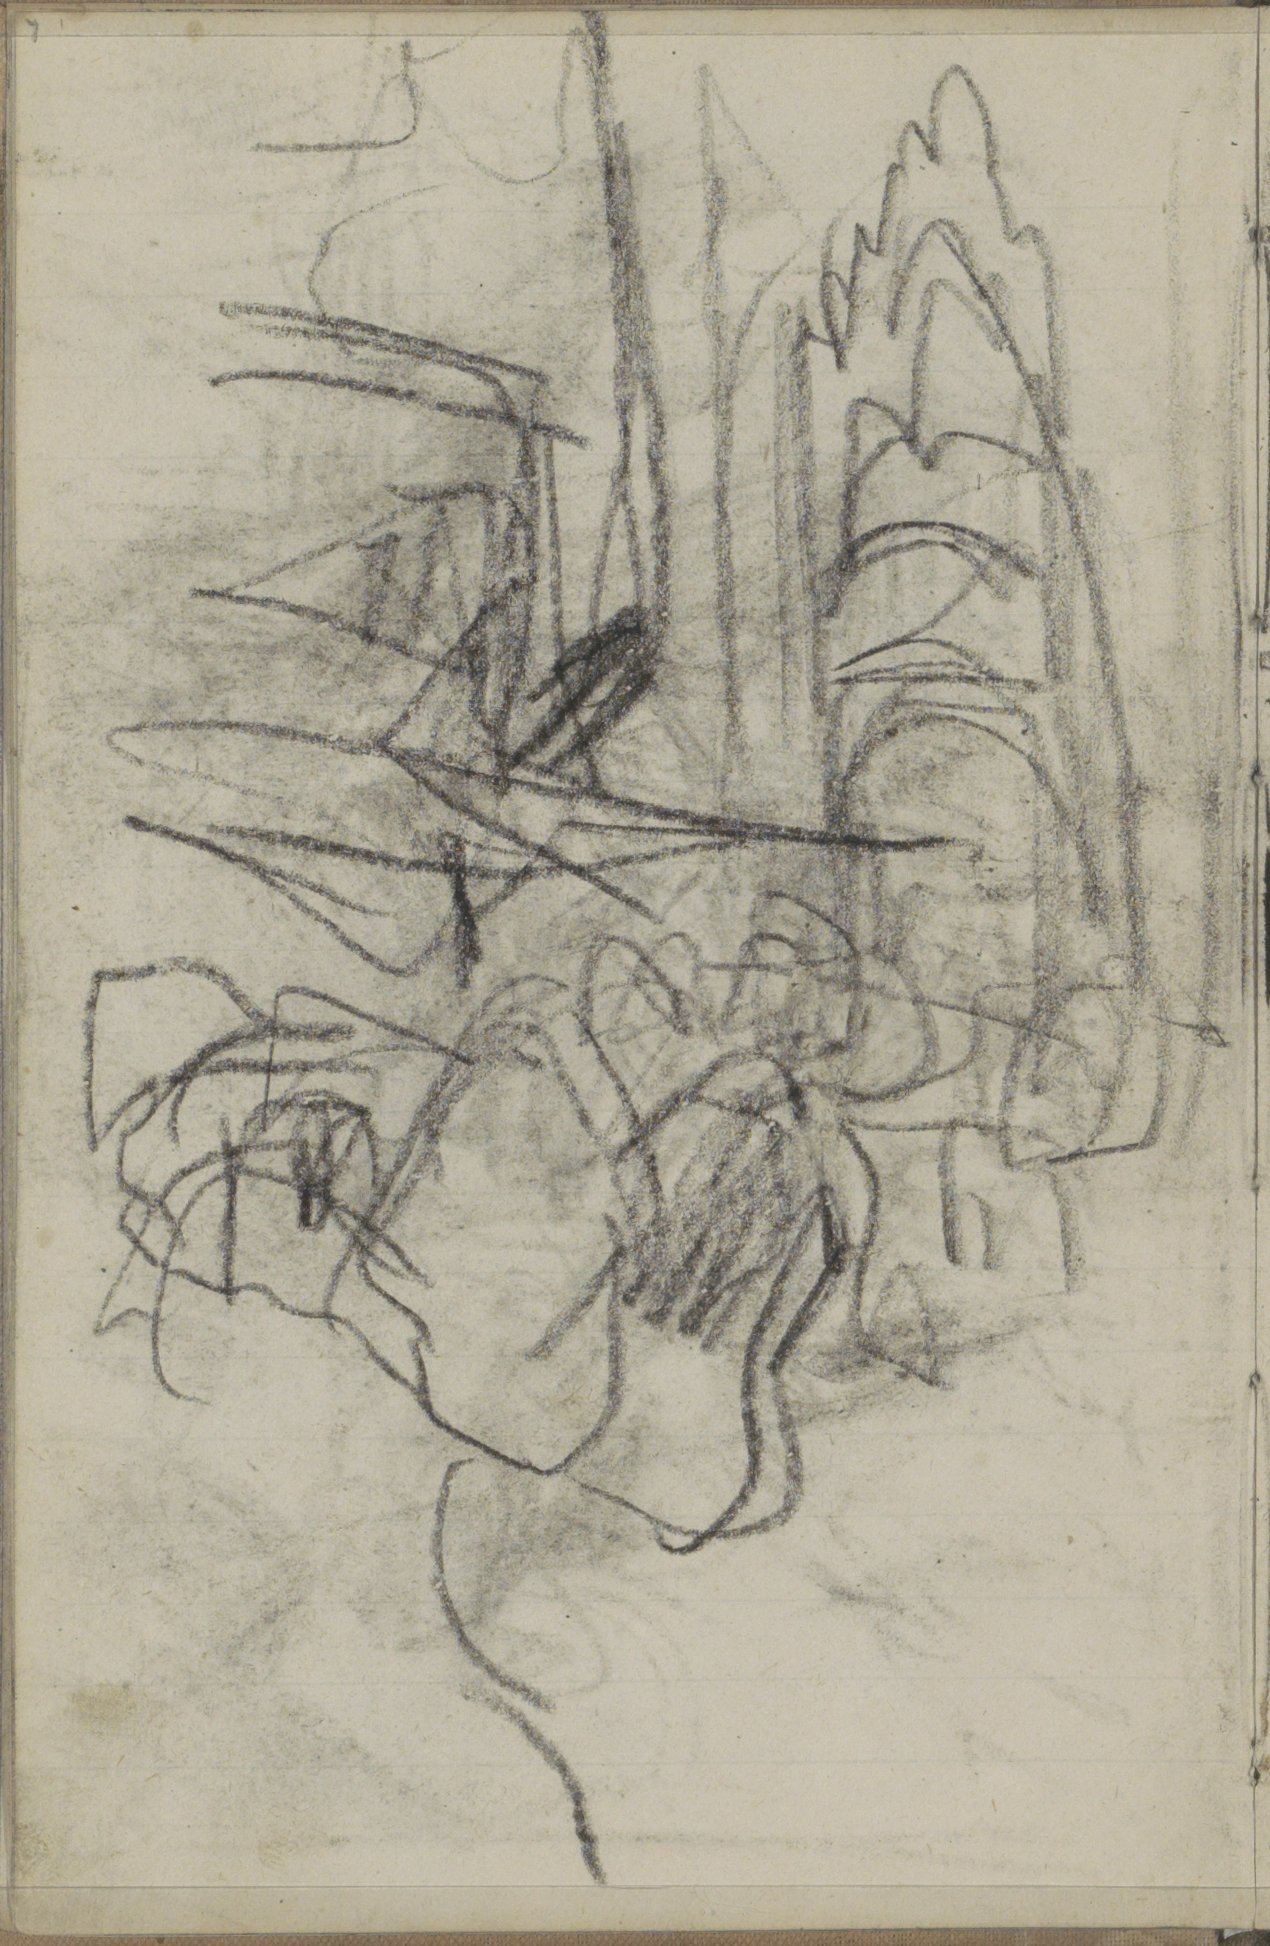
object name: sketchbook leaf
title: Studieblad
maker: marius bauer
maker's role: draughtsman, print maker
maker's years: 1867-1932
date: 1888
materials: chalk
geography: istanbul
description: Pagina 7 uit een schetsboek met 56 bladen.